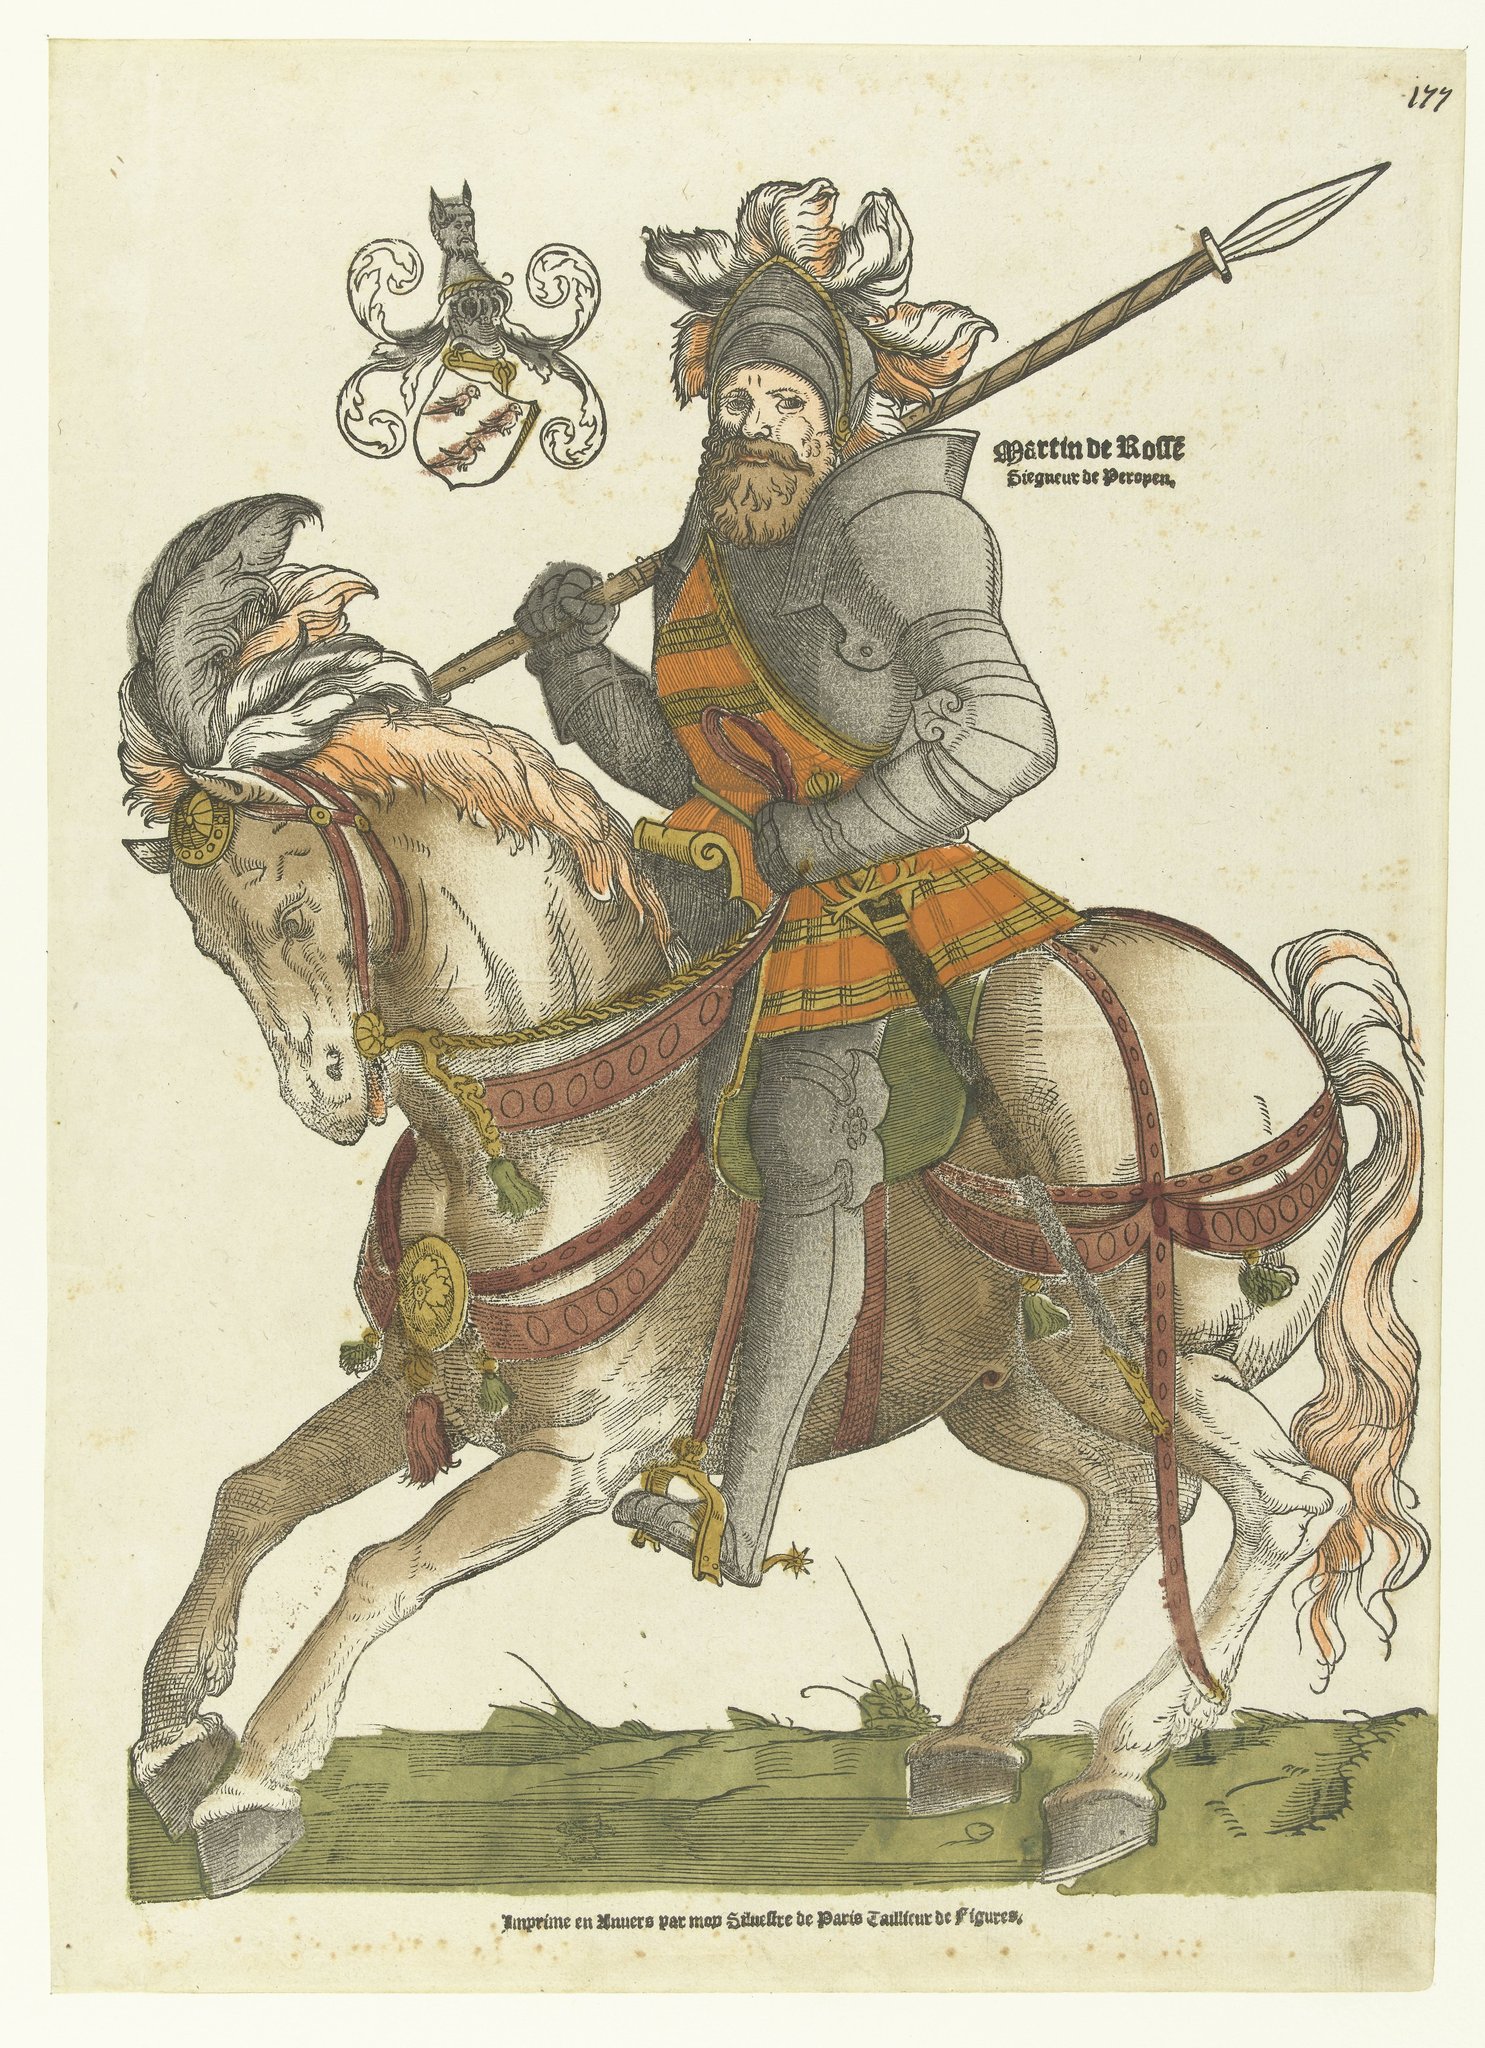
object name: print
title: Martin de Rosse Siegneur de Peroyen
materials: paper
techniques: woodcut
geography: antwerp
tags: equestrian state-portrait, historical persons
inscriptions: number: ‘177’, address: ‘Imprime en Anvers par moy Silvestre de Paris Tailleur de Figures’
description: Maarten van Rossum was heer van Poederoyen in de Betuwe, veldheer onder Karel van Egmont en in dienst van Willem van Gulik, Berg en Kleef. Hij speelde een belangrijke rol in de Gelderse opstand. Gedurende de laatste jaren van zijn leven was hij in dienst van keizer Karel V. In harnas op weerbarstig paard. Linksboven zijn wapen.